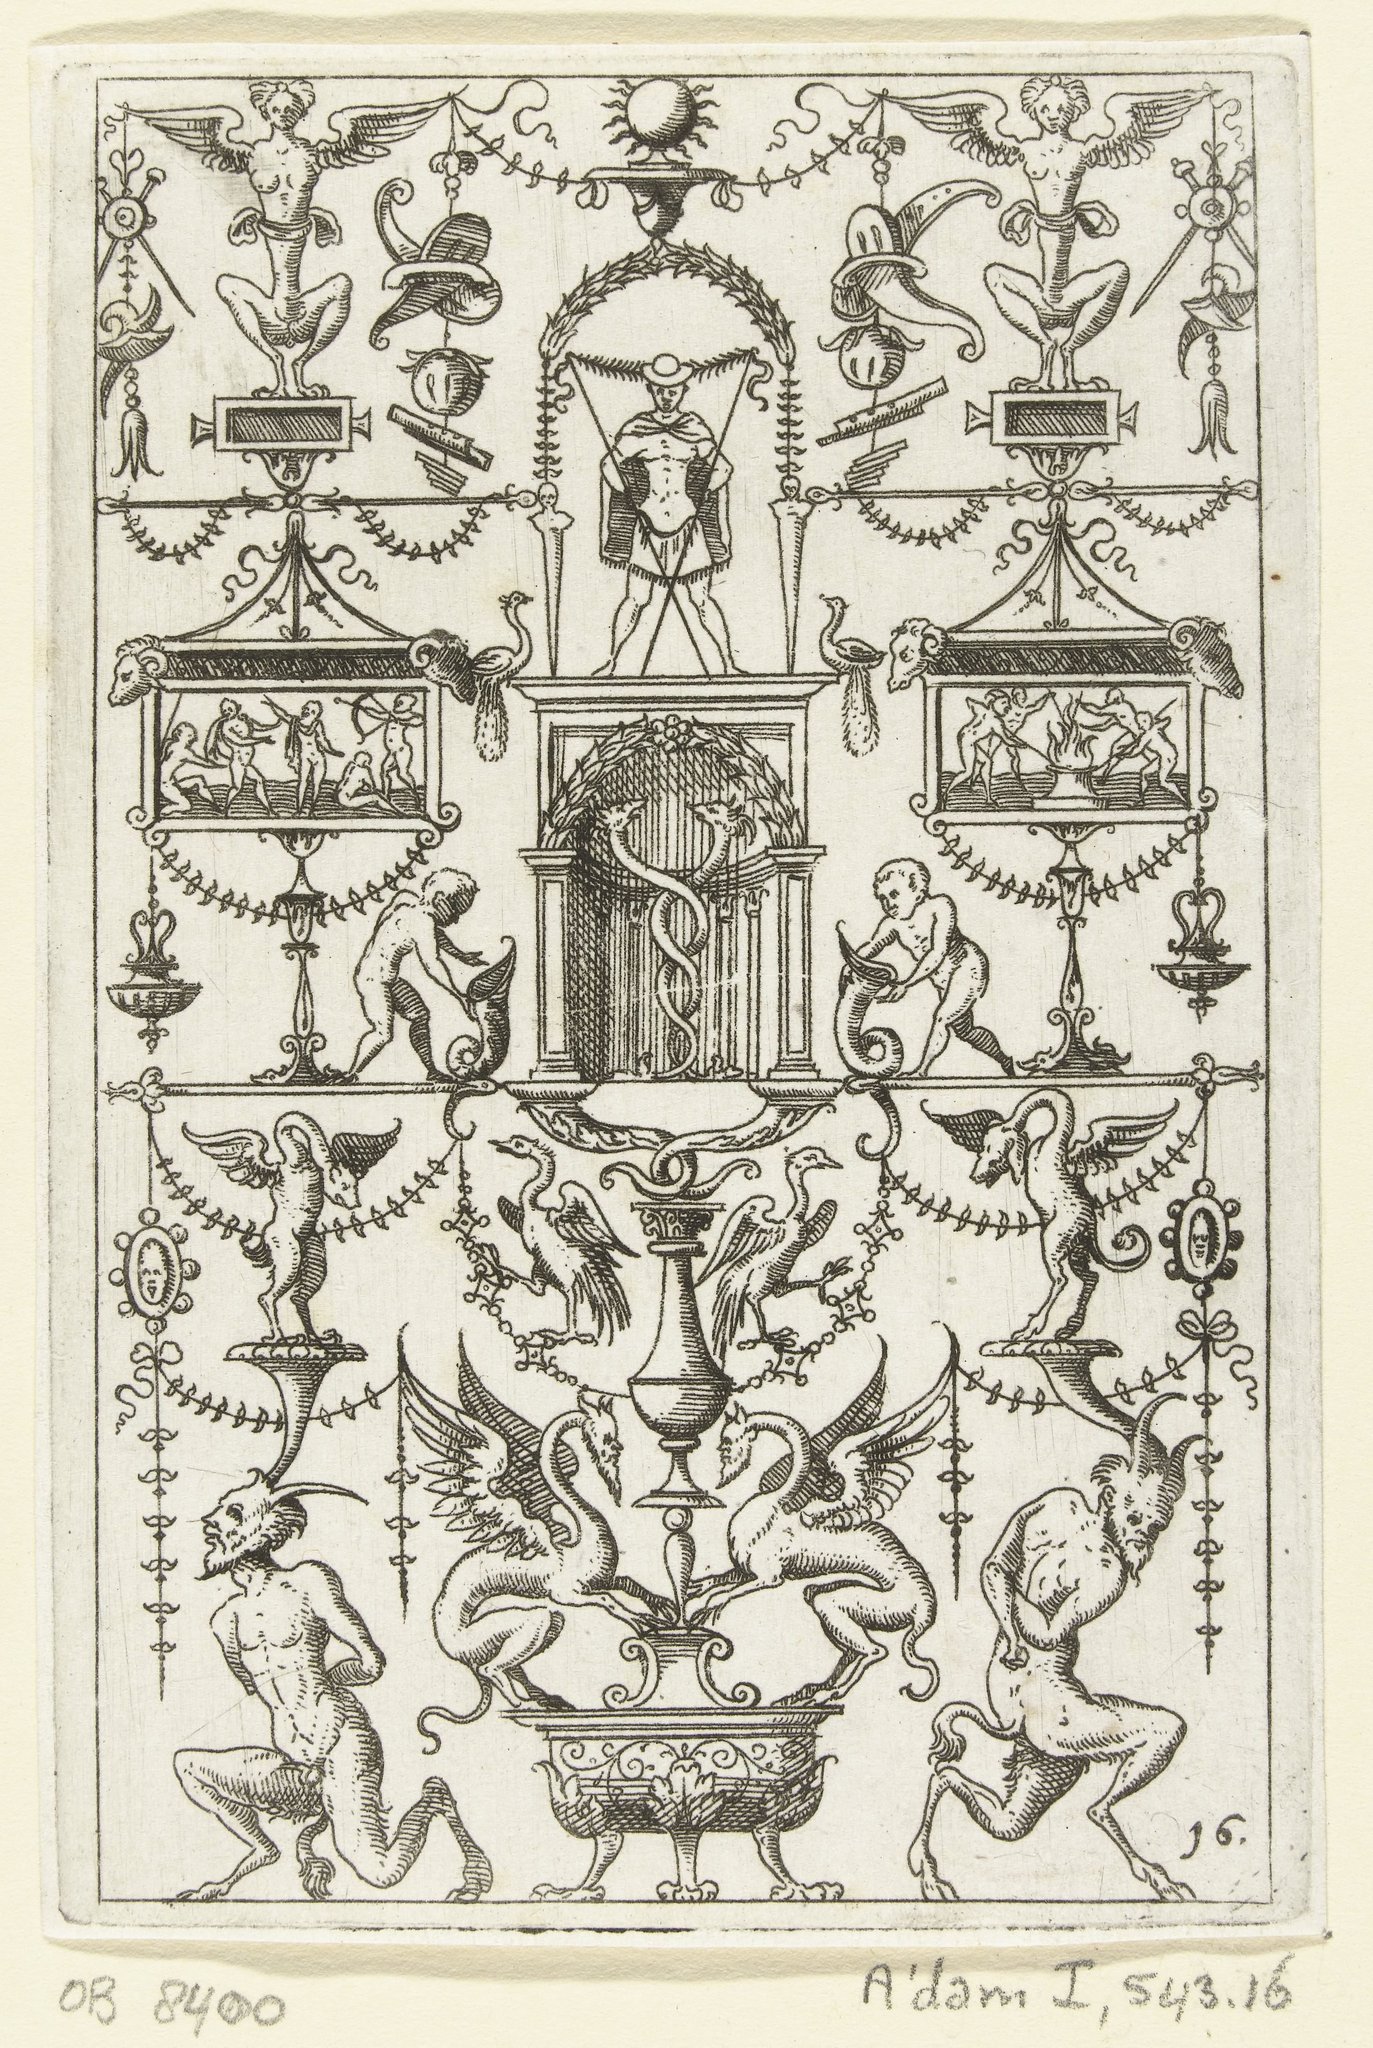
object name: print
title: Iacobus Androuetius Du Cerceau inventor ante annos non paucos conscripsit (...)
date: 1525-1594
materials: paper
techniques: etching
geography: france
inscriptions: collector's mark: Lugt 240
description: Blad uit serie met architectuurfantasieën en grotesken met fabelwezens, guirlandes, kandelabers en mascarons.